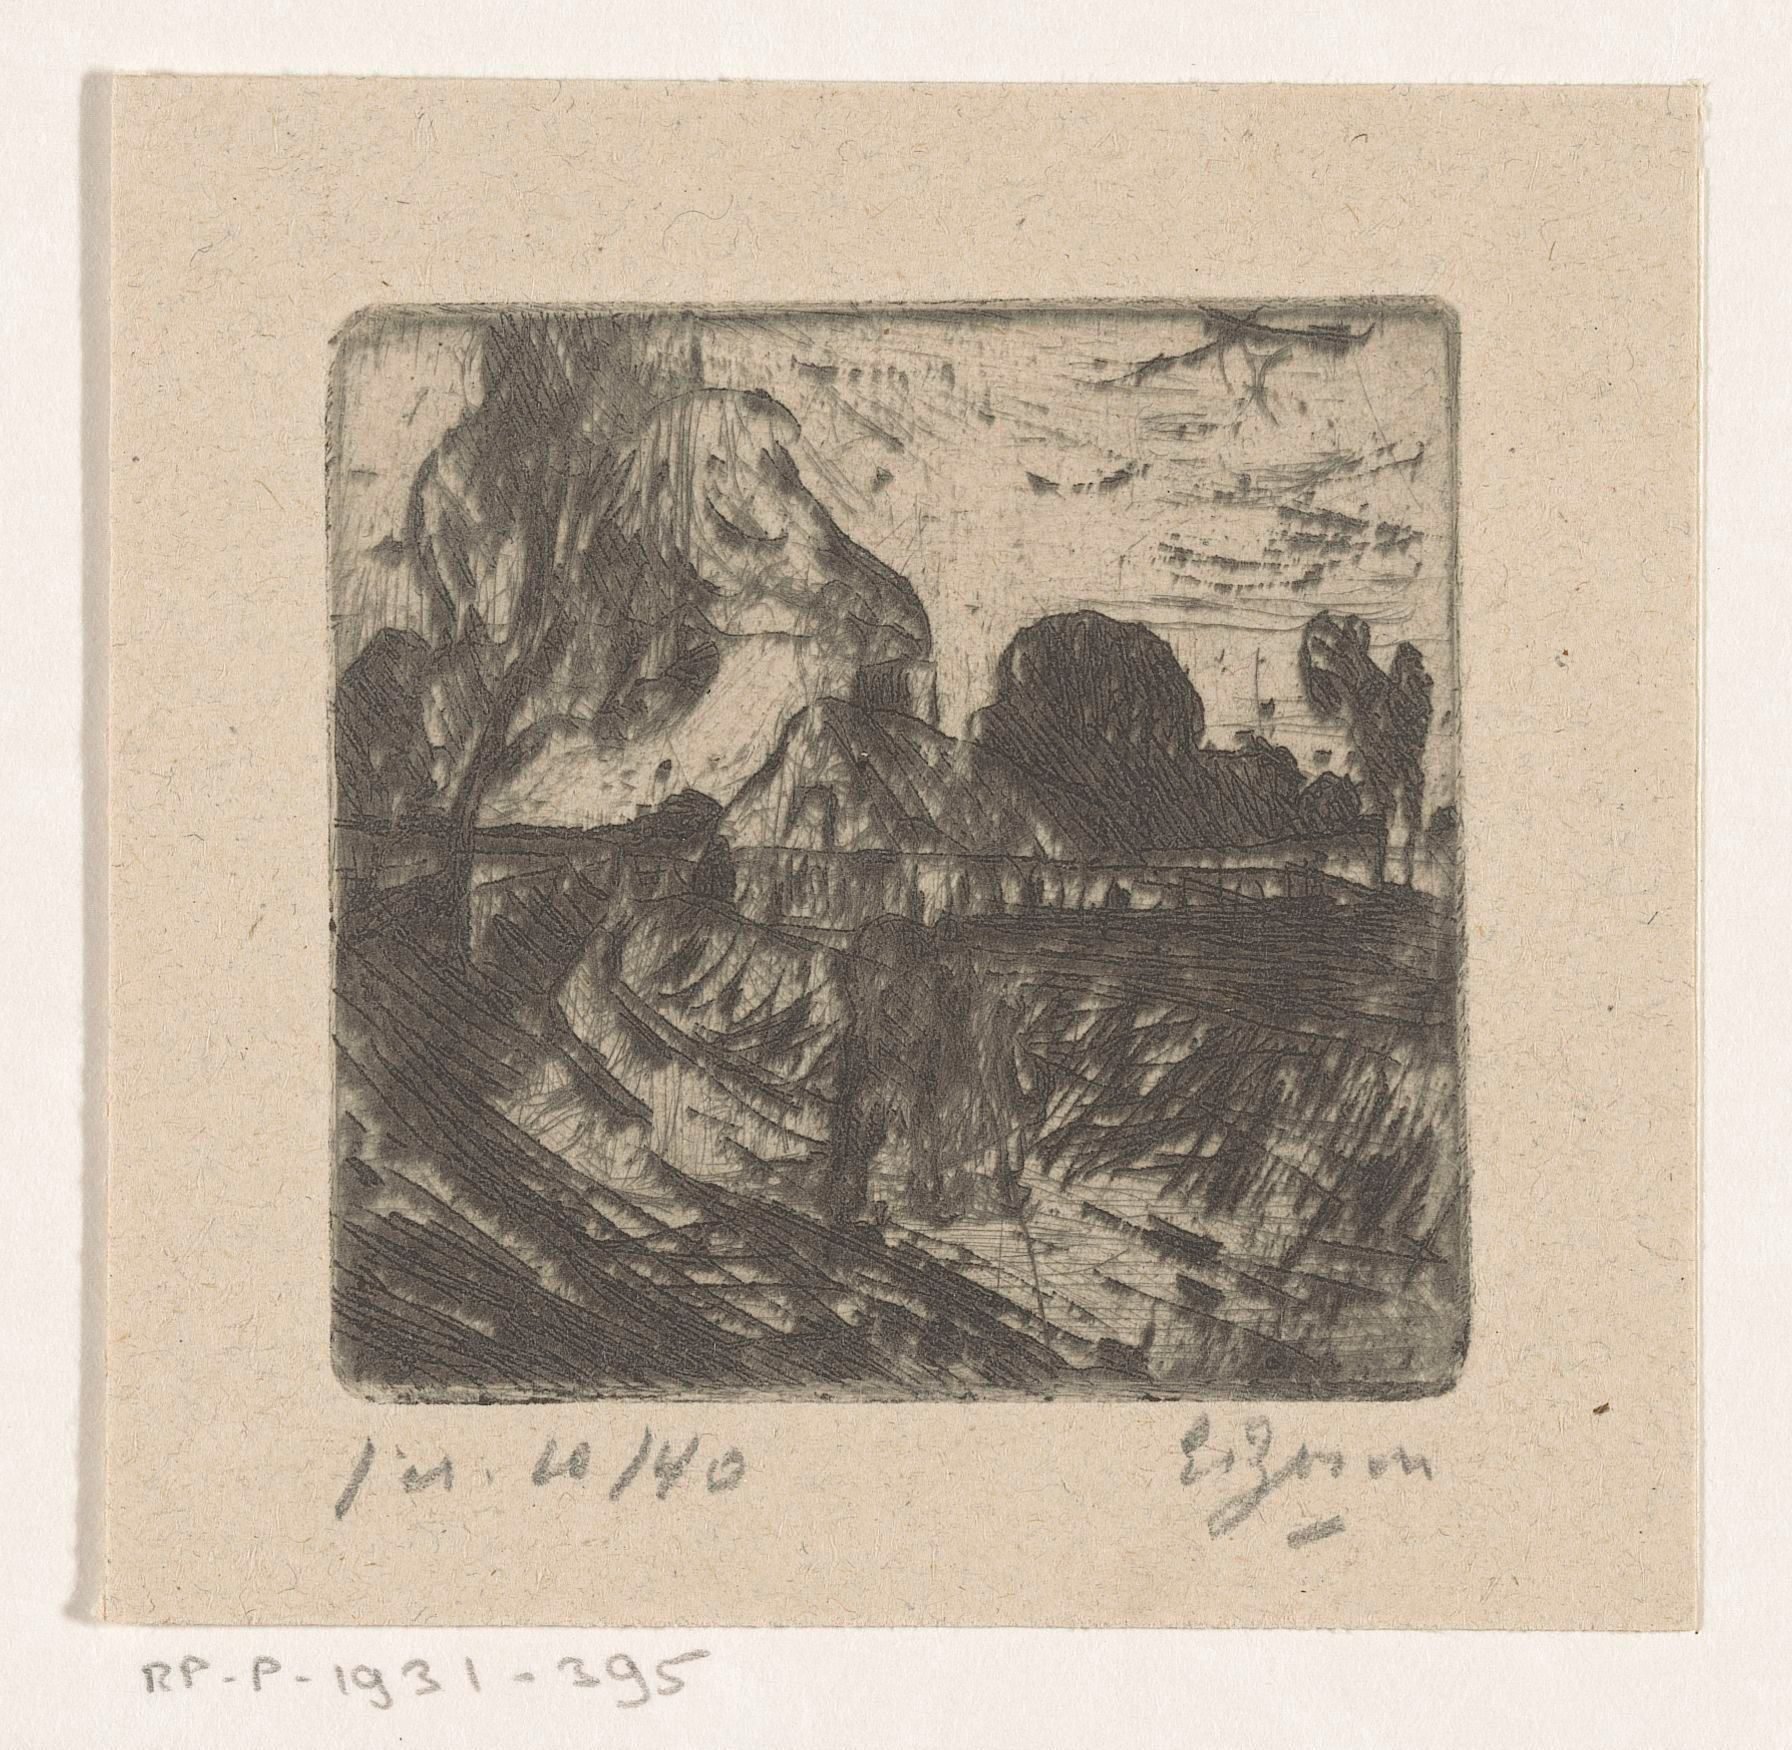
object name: print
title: Landschap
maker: etienne bosch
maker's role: print maker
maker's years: 1863-1933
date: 1873-1931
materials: paper, ink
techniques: drypoint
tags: farm or solitary house in landscape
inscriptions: edition: ‘1e et. 10/40’, collector's mark: Lugt 2228, signature: ‘E.Bosch’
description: Boerenwoning in een landschap; schetsmatig weergegeven.